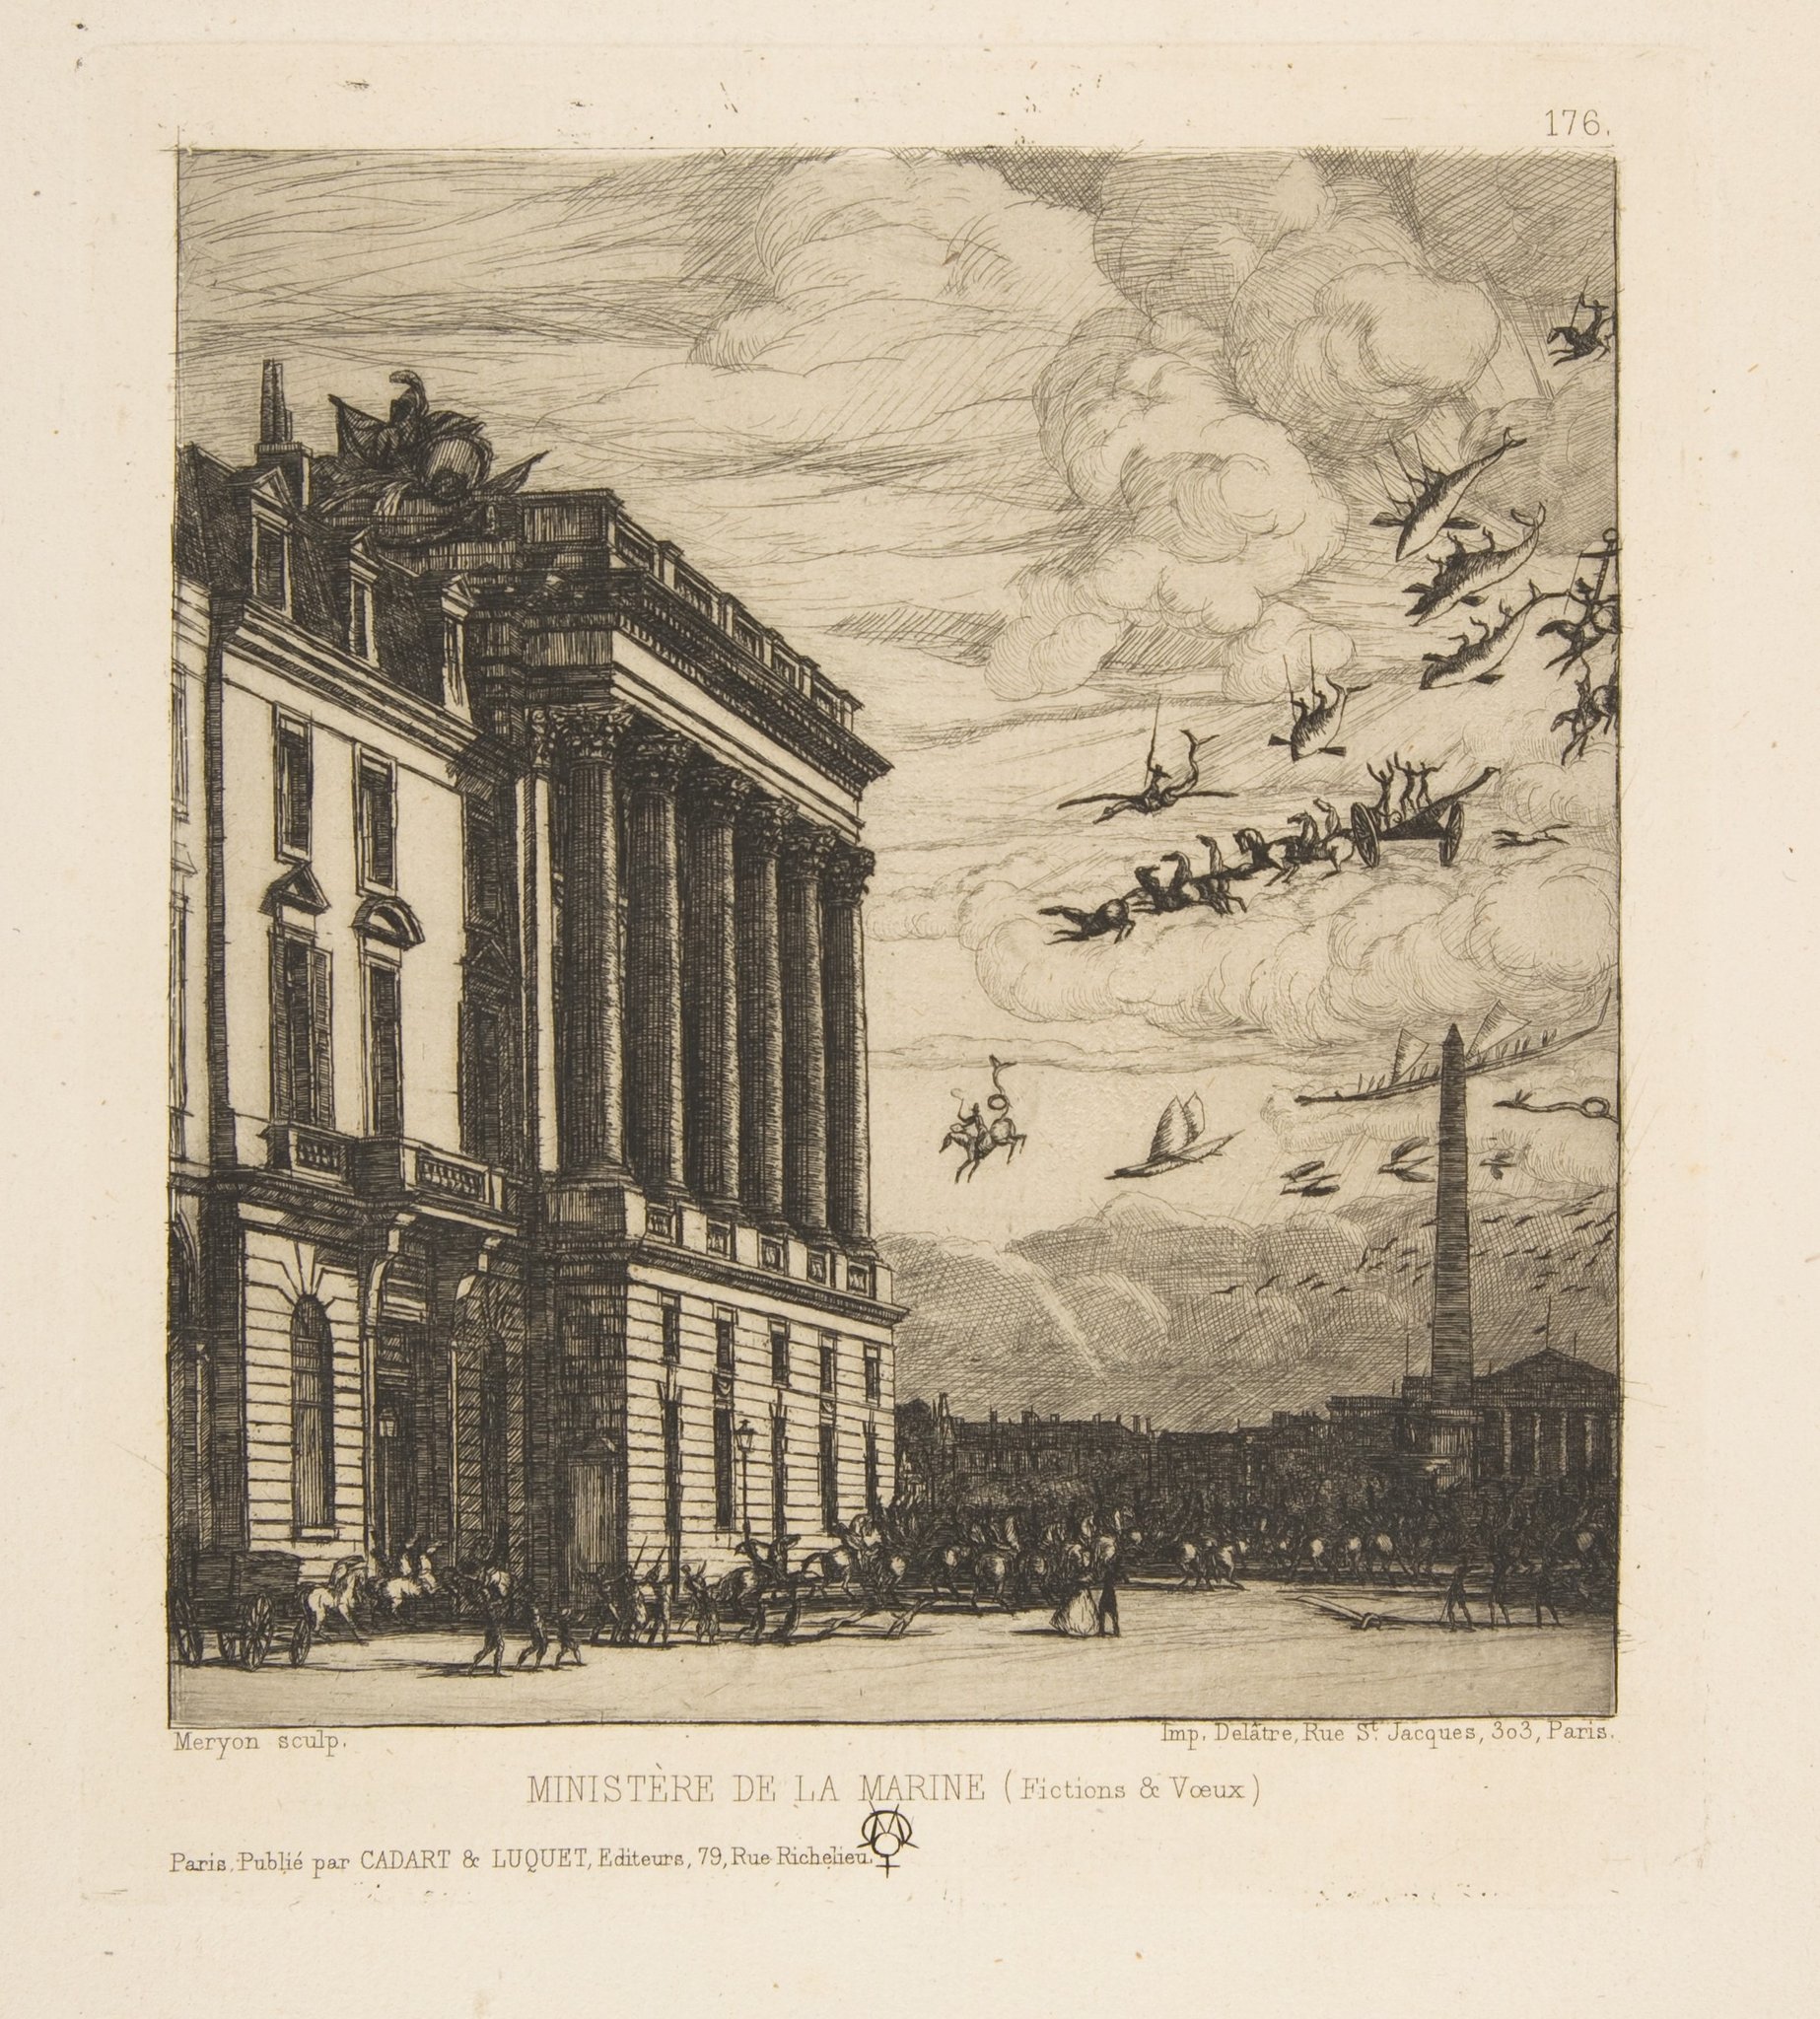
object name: print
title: The Admiralty, Paris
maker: charles meryon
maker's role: artist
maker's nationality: french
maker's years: 1821-1868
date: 1865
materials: paper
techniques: etching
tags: buildings,fish,chariots,paris